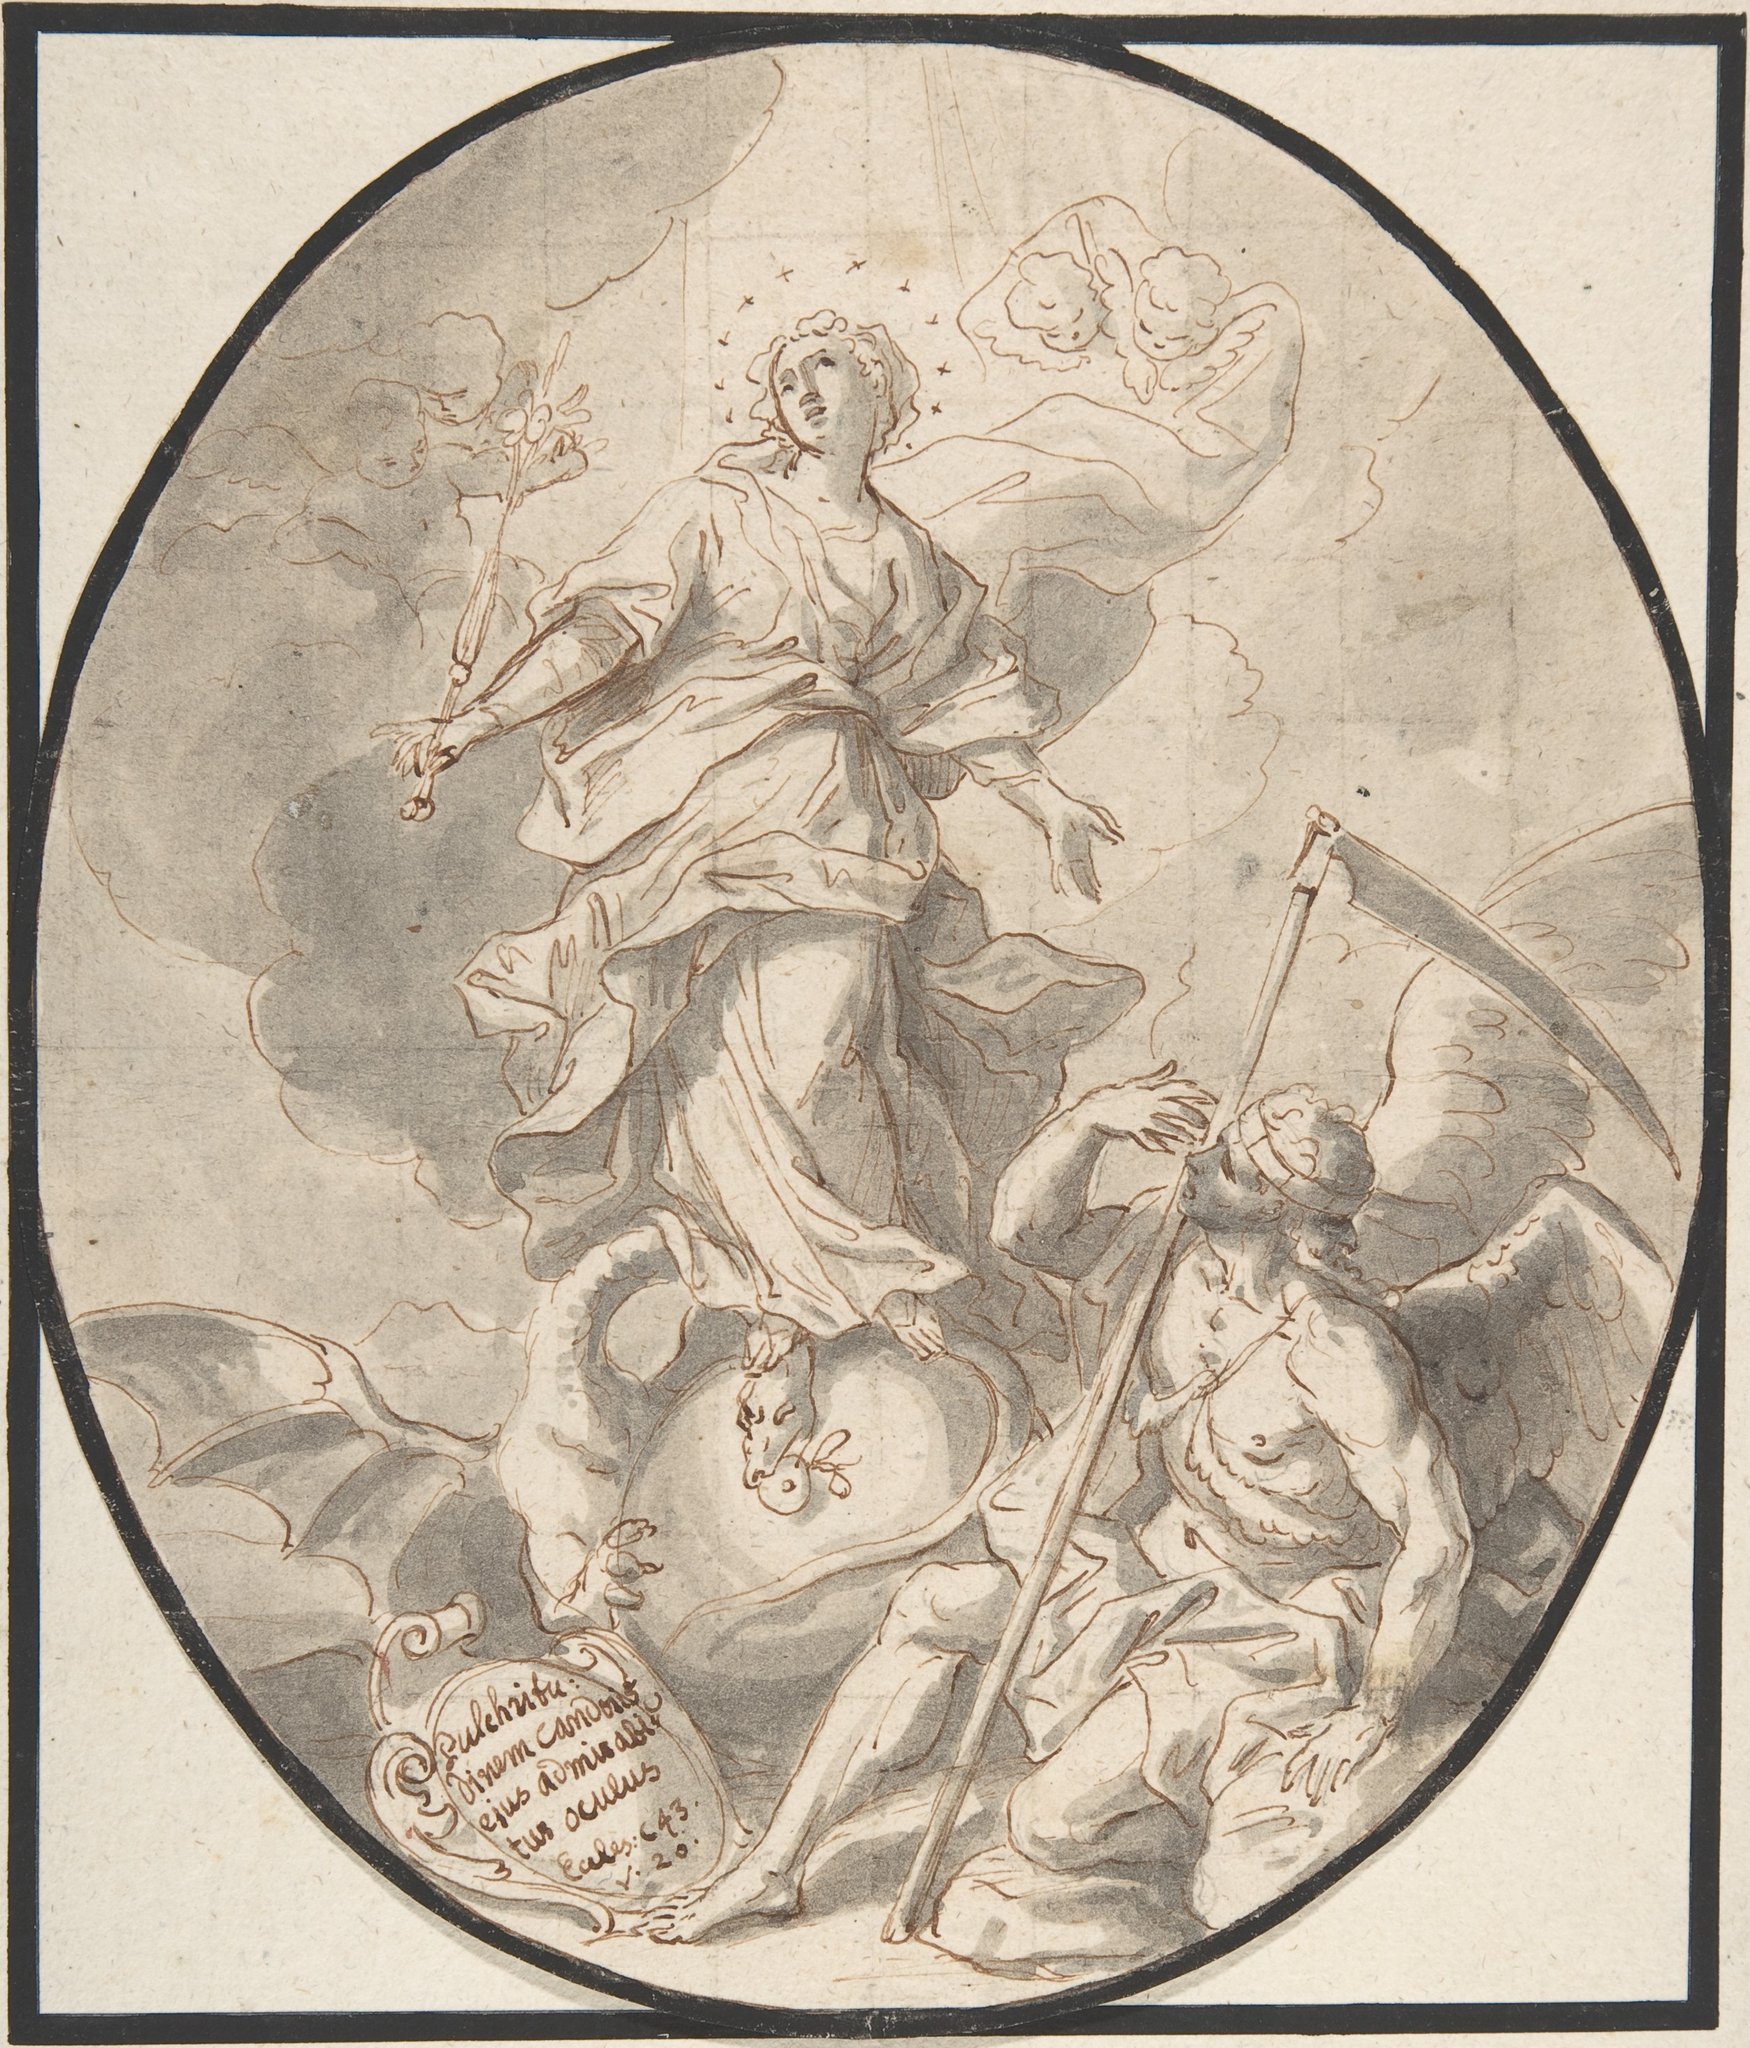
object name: drawing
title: The Immaculate Virgin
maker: johann georg bergmüller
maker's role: artist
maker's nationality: german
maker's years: 1688-1762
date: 1701-1766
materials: chalk, ink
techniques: brush, pen, drawing, transfer, wash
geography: netherlands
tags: angels,virgin mary